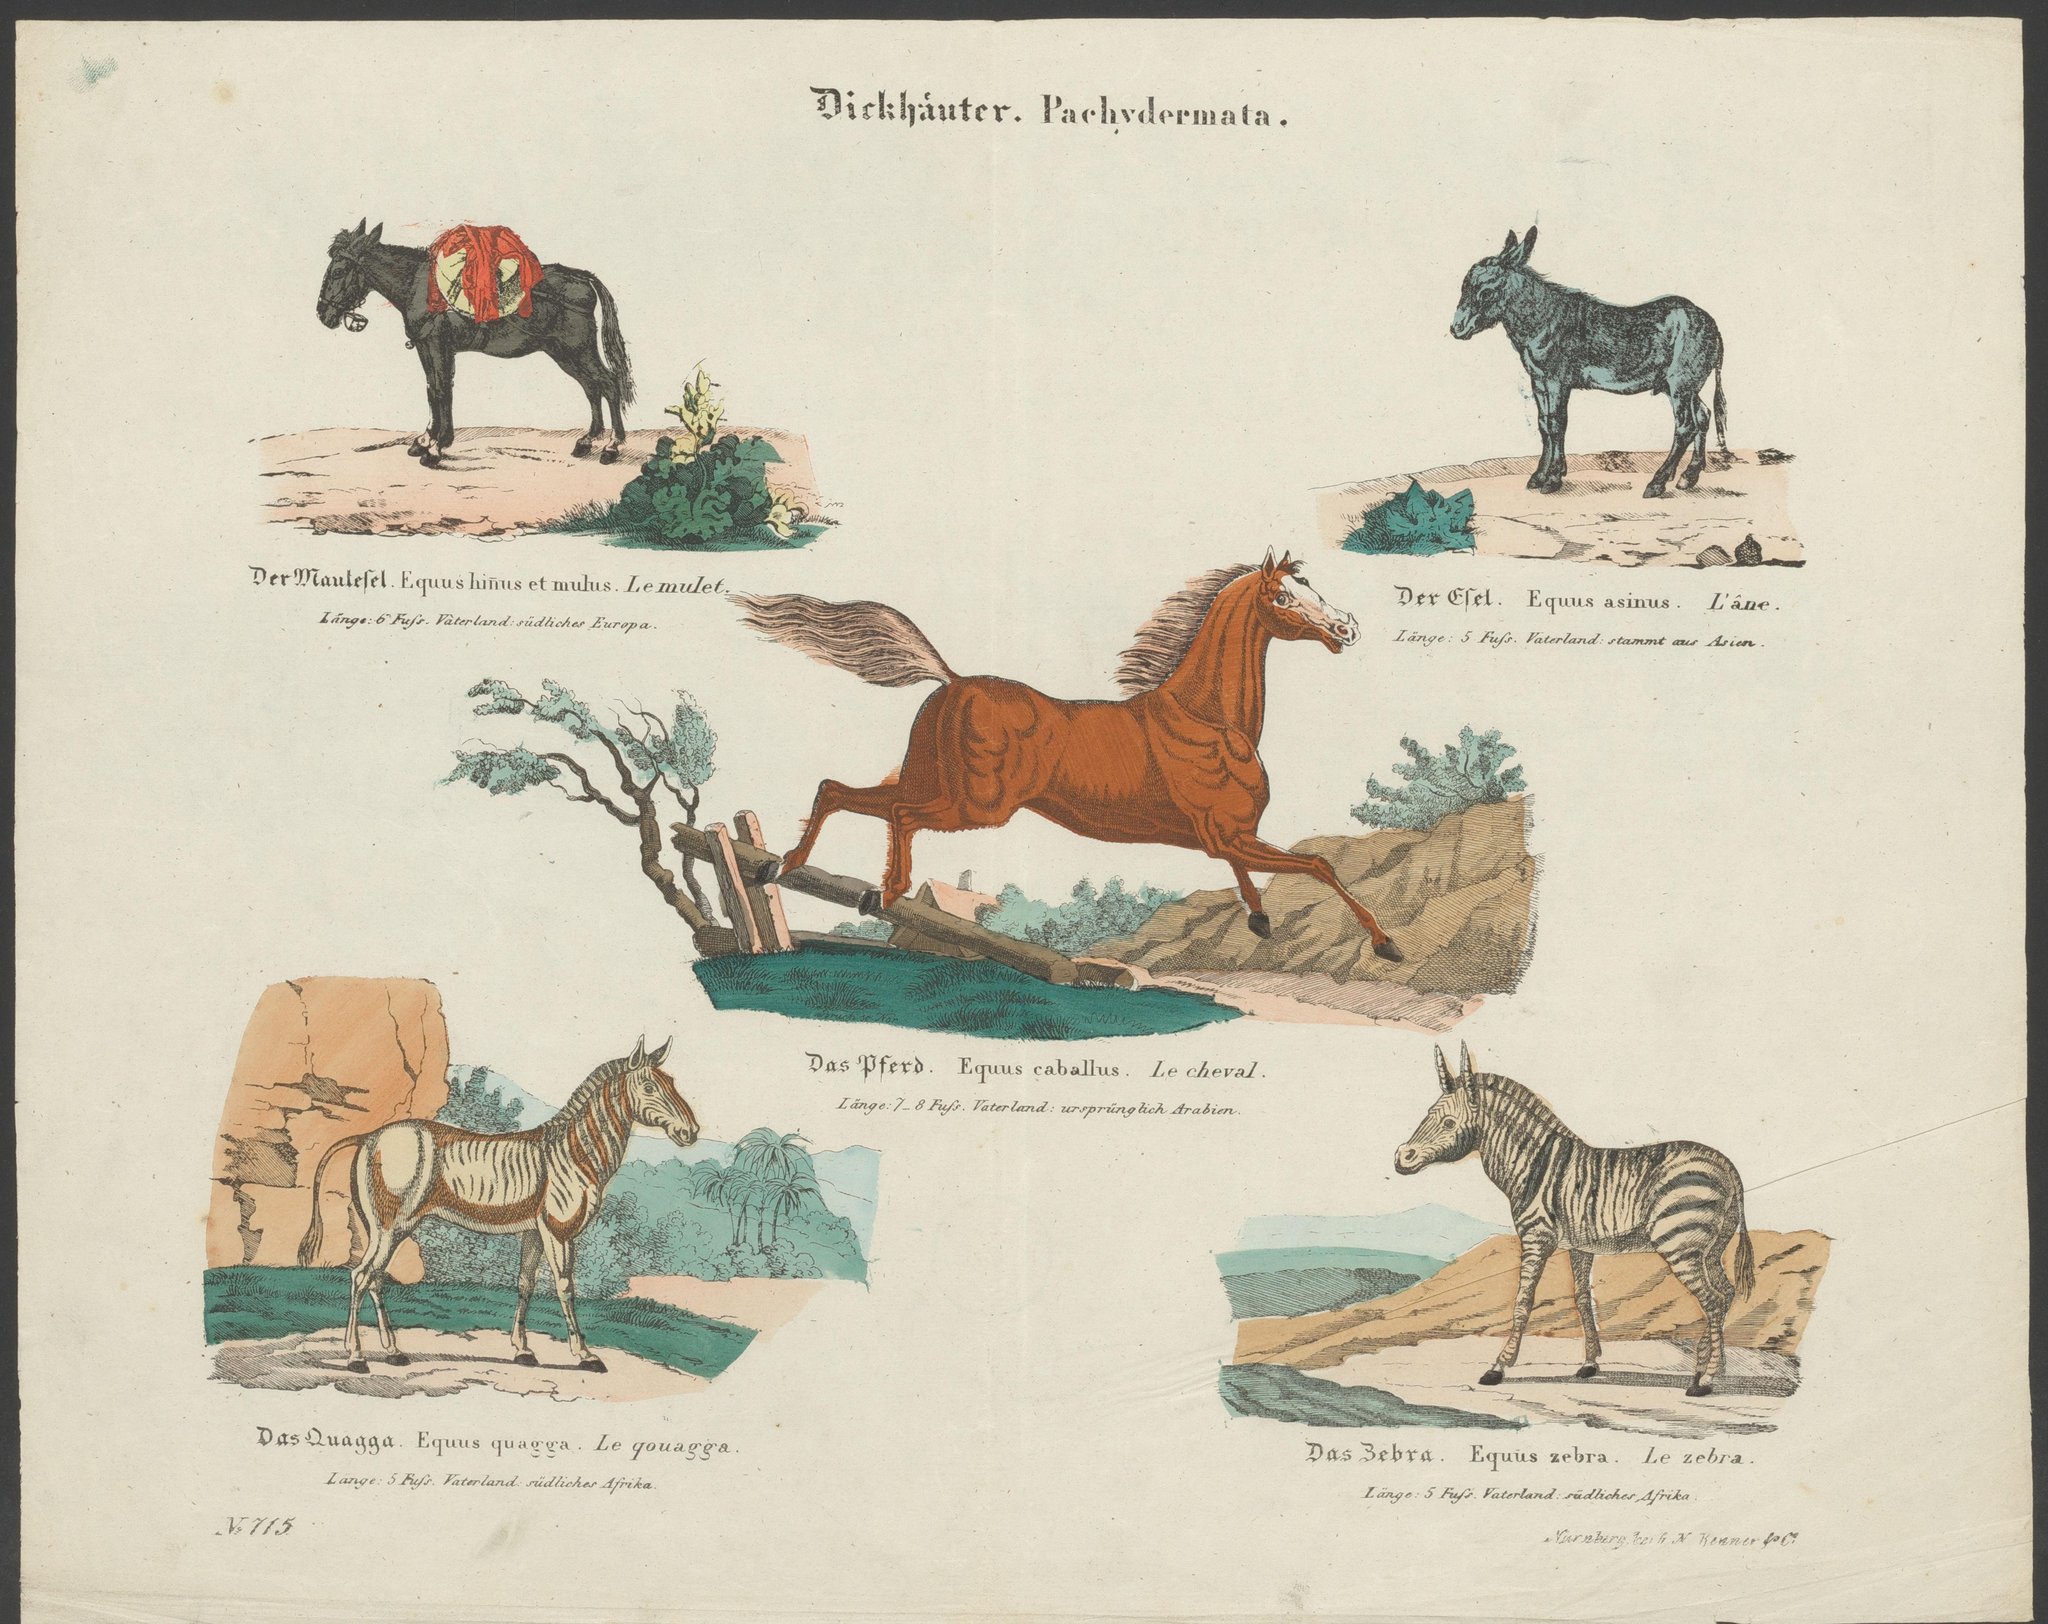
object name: print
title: Dickhauter.Pachydermata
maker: Anonymous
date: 1837-1868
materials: paper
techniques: hand coloring, lithograph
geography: nuremberg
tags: hoofed animals (with name), horse, mule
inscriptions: collector's mark: Lugt 1641, stamp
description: Vijf voorstellingen van diverse soorten paardachtigen. Onder iedere voorstelling de naam van het soort in het Duits, Latijn en Frans. Daaronder de afmeting en land van herkomst van het dier. Linksonder genummerd: No. 715. Onderwerpsrubrieken binnen de Atlas Zeden en Gewoonten: Zeden en Gewoonten in Engeren Zin, Des menschen beging, midden en einde, Kinderleven – Kinderspel en Kinderprenten.